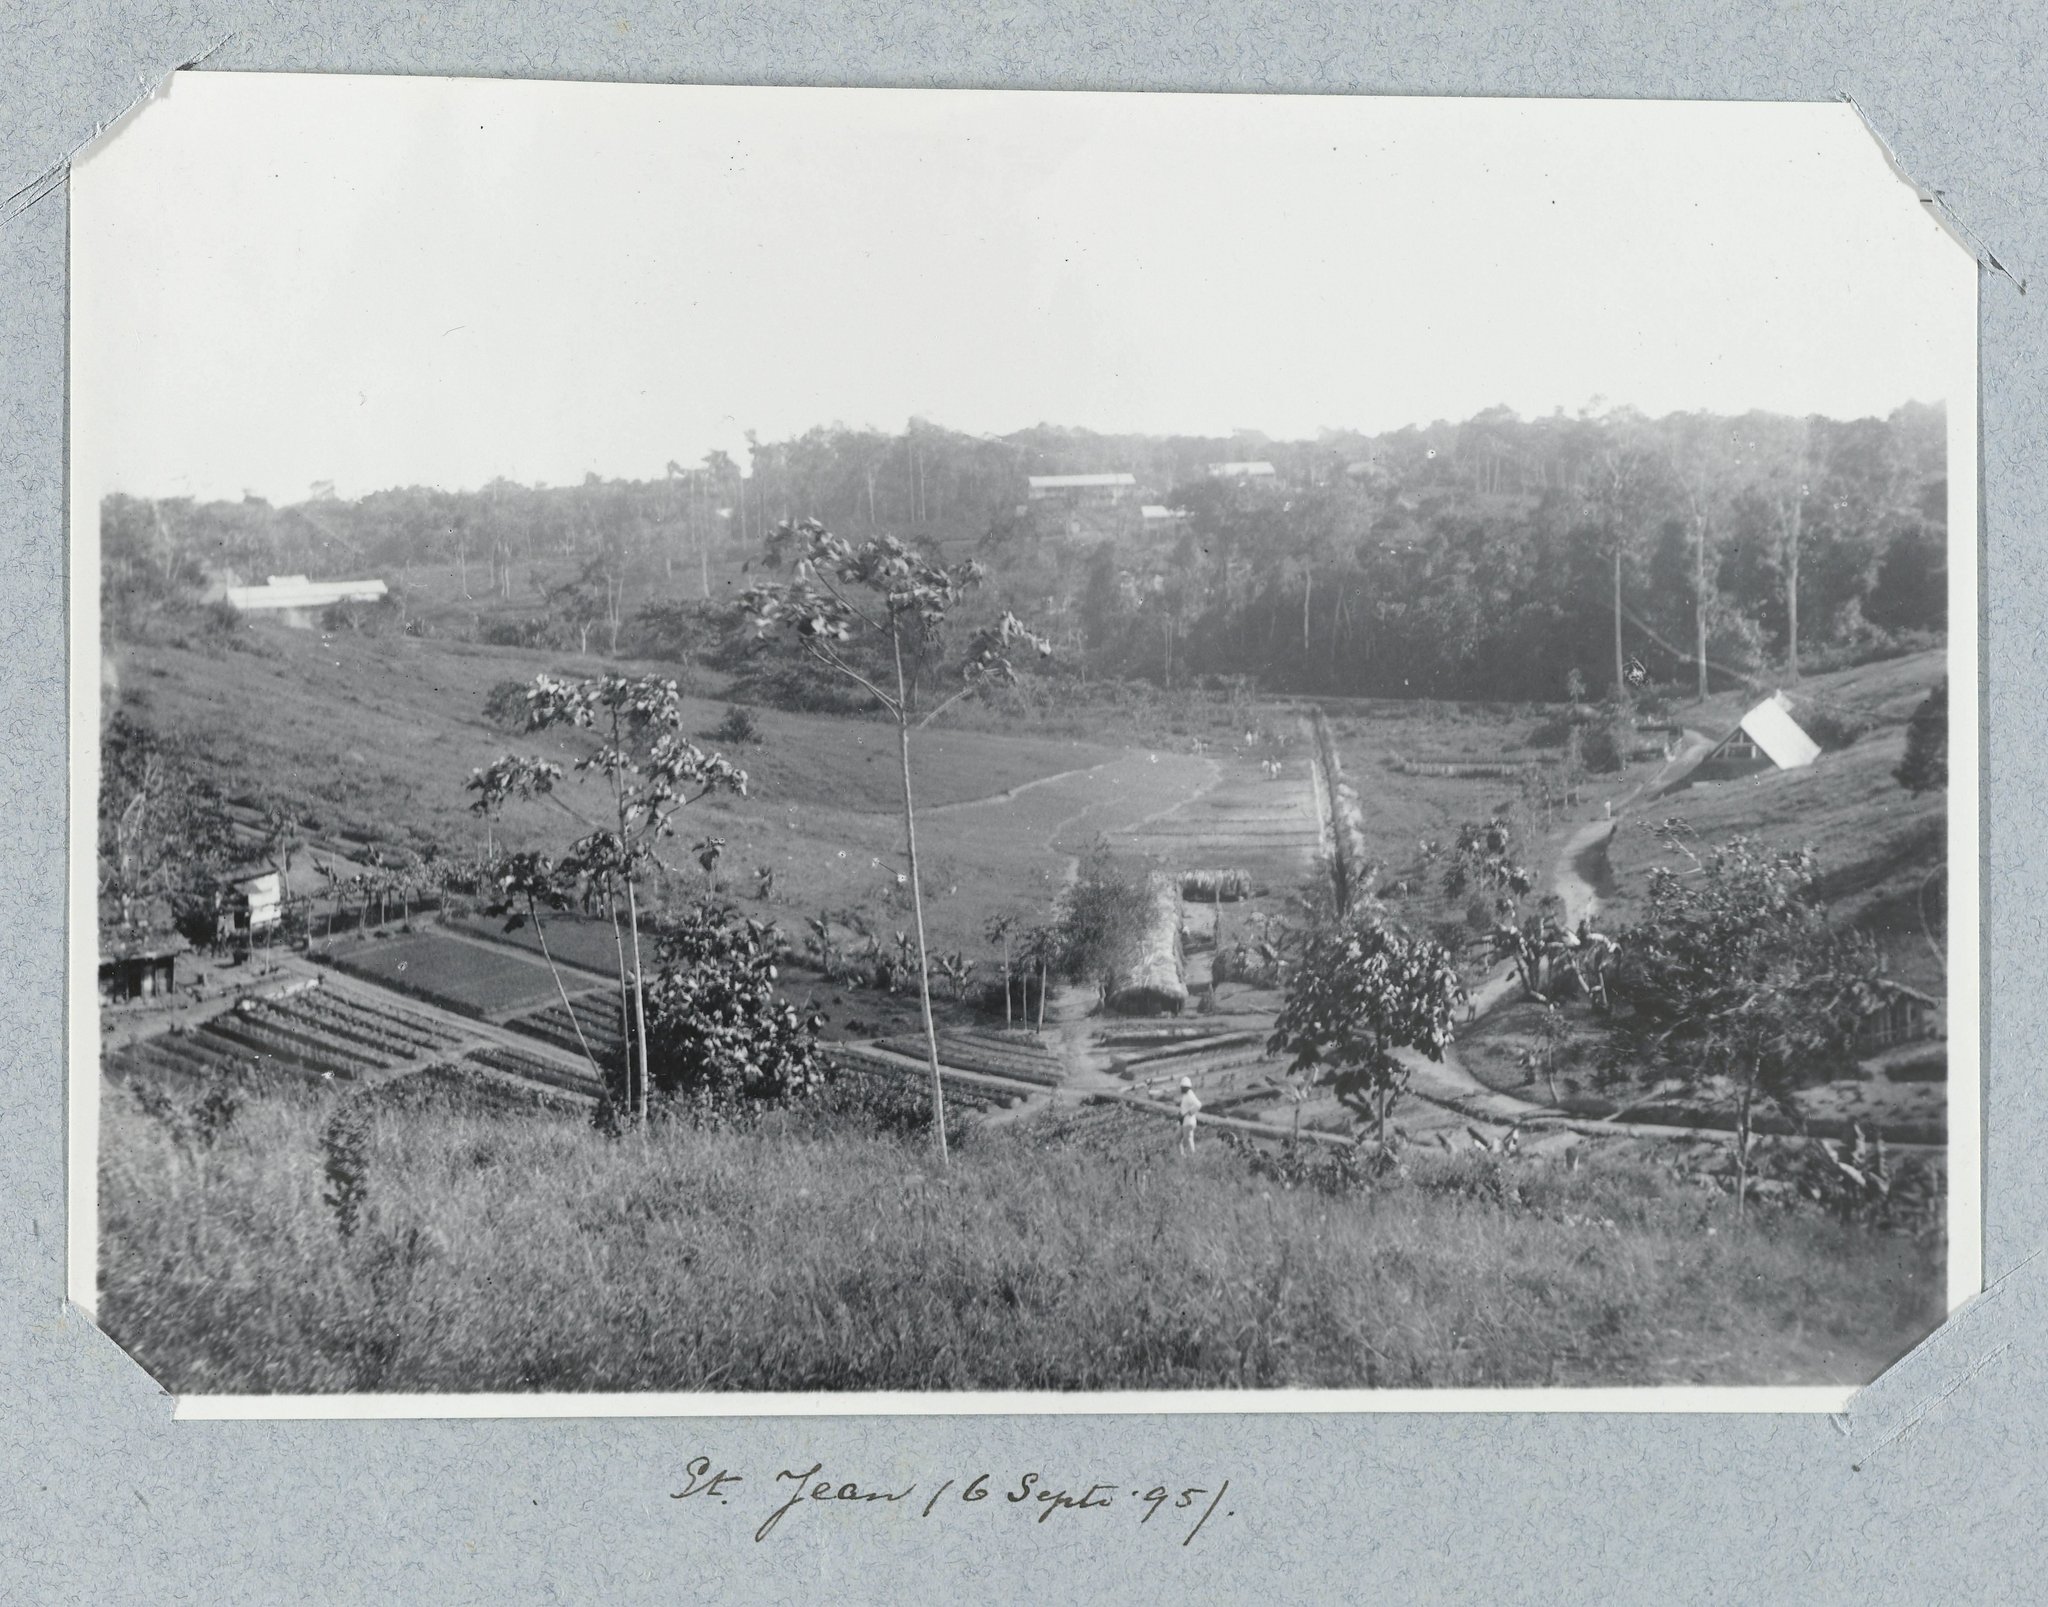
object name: photograph album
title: Suriname 1895-1898, 'Souvenirs de Voyage'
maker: théodore van lelyveld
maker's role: painter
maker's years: 1867-1954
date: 1895-1898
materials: paper, photographic support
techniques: gelatin silver print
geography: suriname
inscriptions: title: ‘Souvenirs de Voyage’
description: Een fotoalbum over Suriname met 134 foto's van Théodore B. van Lelyveld uit de jaren 1895-1898. Théodore van Lelyveld was de adjudant van Jhr. Mr. J.A.J. van Asch van Wijk, de gouverneur van Suriname en tevens schilder van botanische voorstellingen. Het album bevat een portret van gouverneur Van Asch van Wijk. Album met band donkerroodbruin linnen met band en hoeken van leer; 50 dubbele bladen van blauwgrijs papier met foto's ingestoken in hoeken of ingeplakt op beide zijden. Bladzijden 82-95 zijn leeg, de laatste bladzijden 96-99 bevatten 13 prentbriefkaarten van Frankrijk. Op de voorzijde in opdruk: Souvenirs de Voyage. Schutbladen van roze gedecoreerd papier.